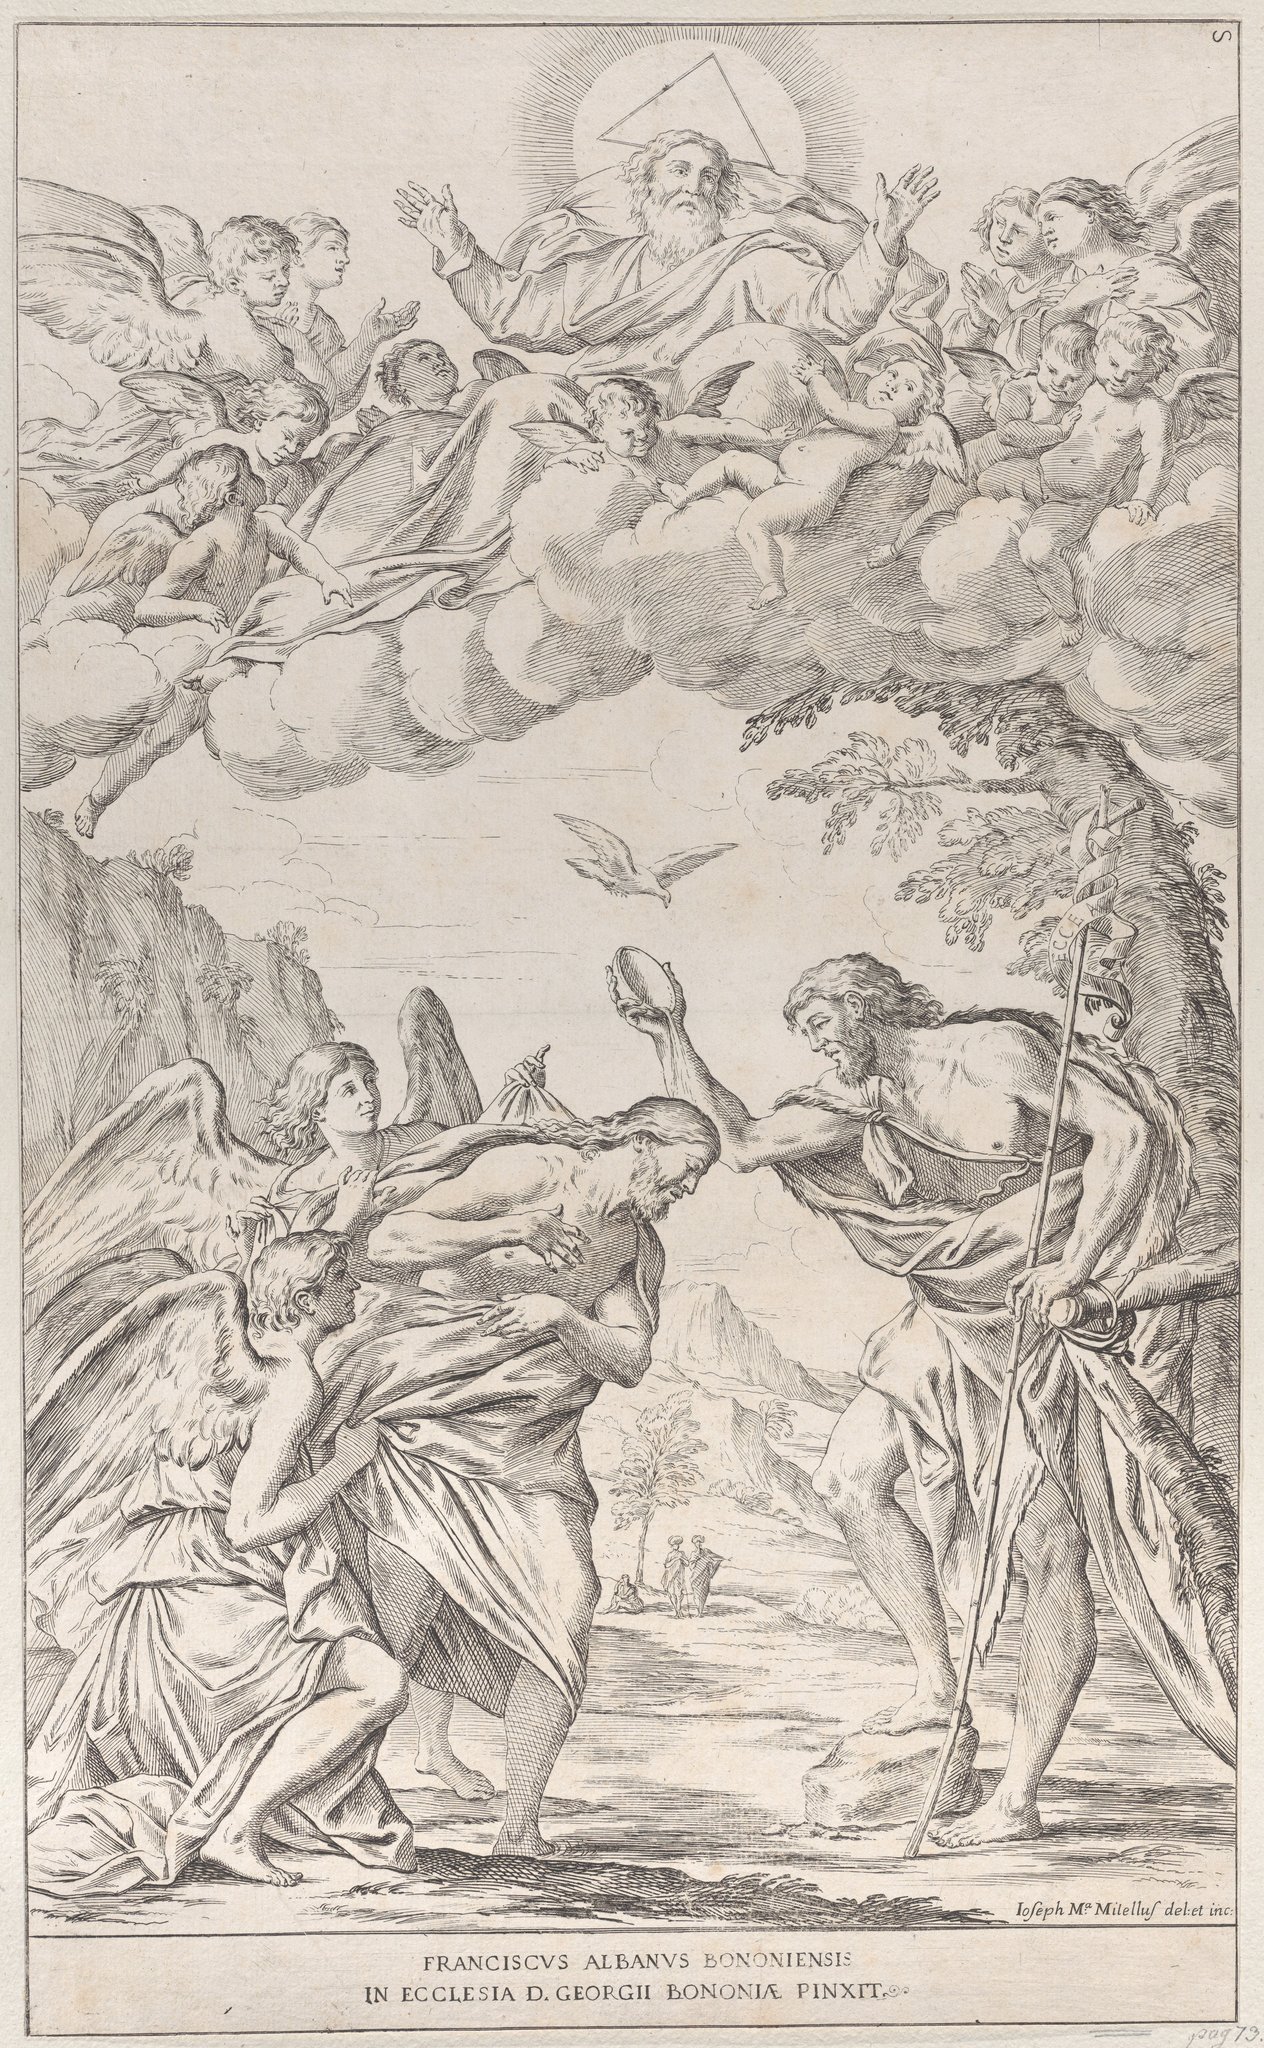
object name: print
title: Plate 8: the Baptism of Christ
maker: giuseppe maria mitelli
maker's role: artist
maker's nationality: italian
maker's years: 1634-1718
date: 1678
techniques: etching